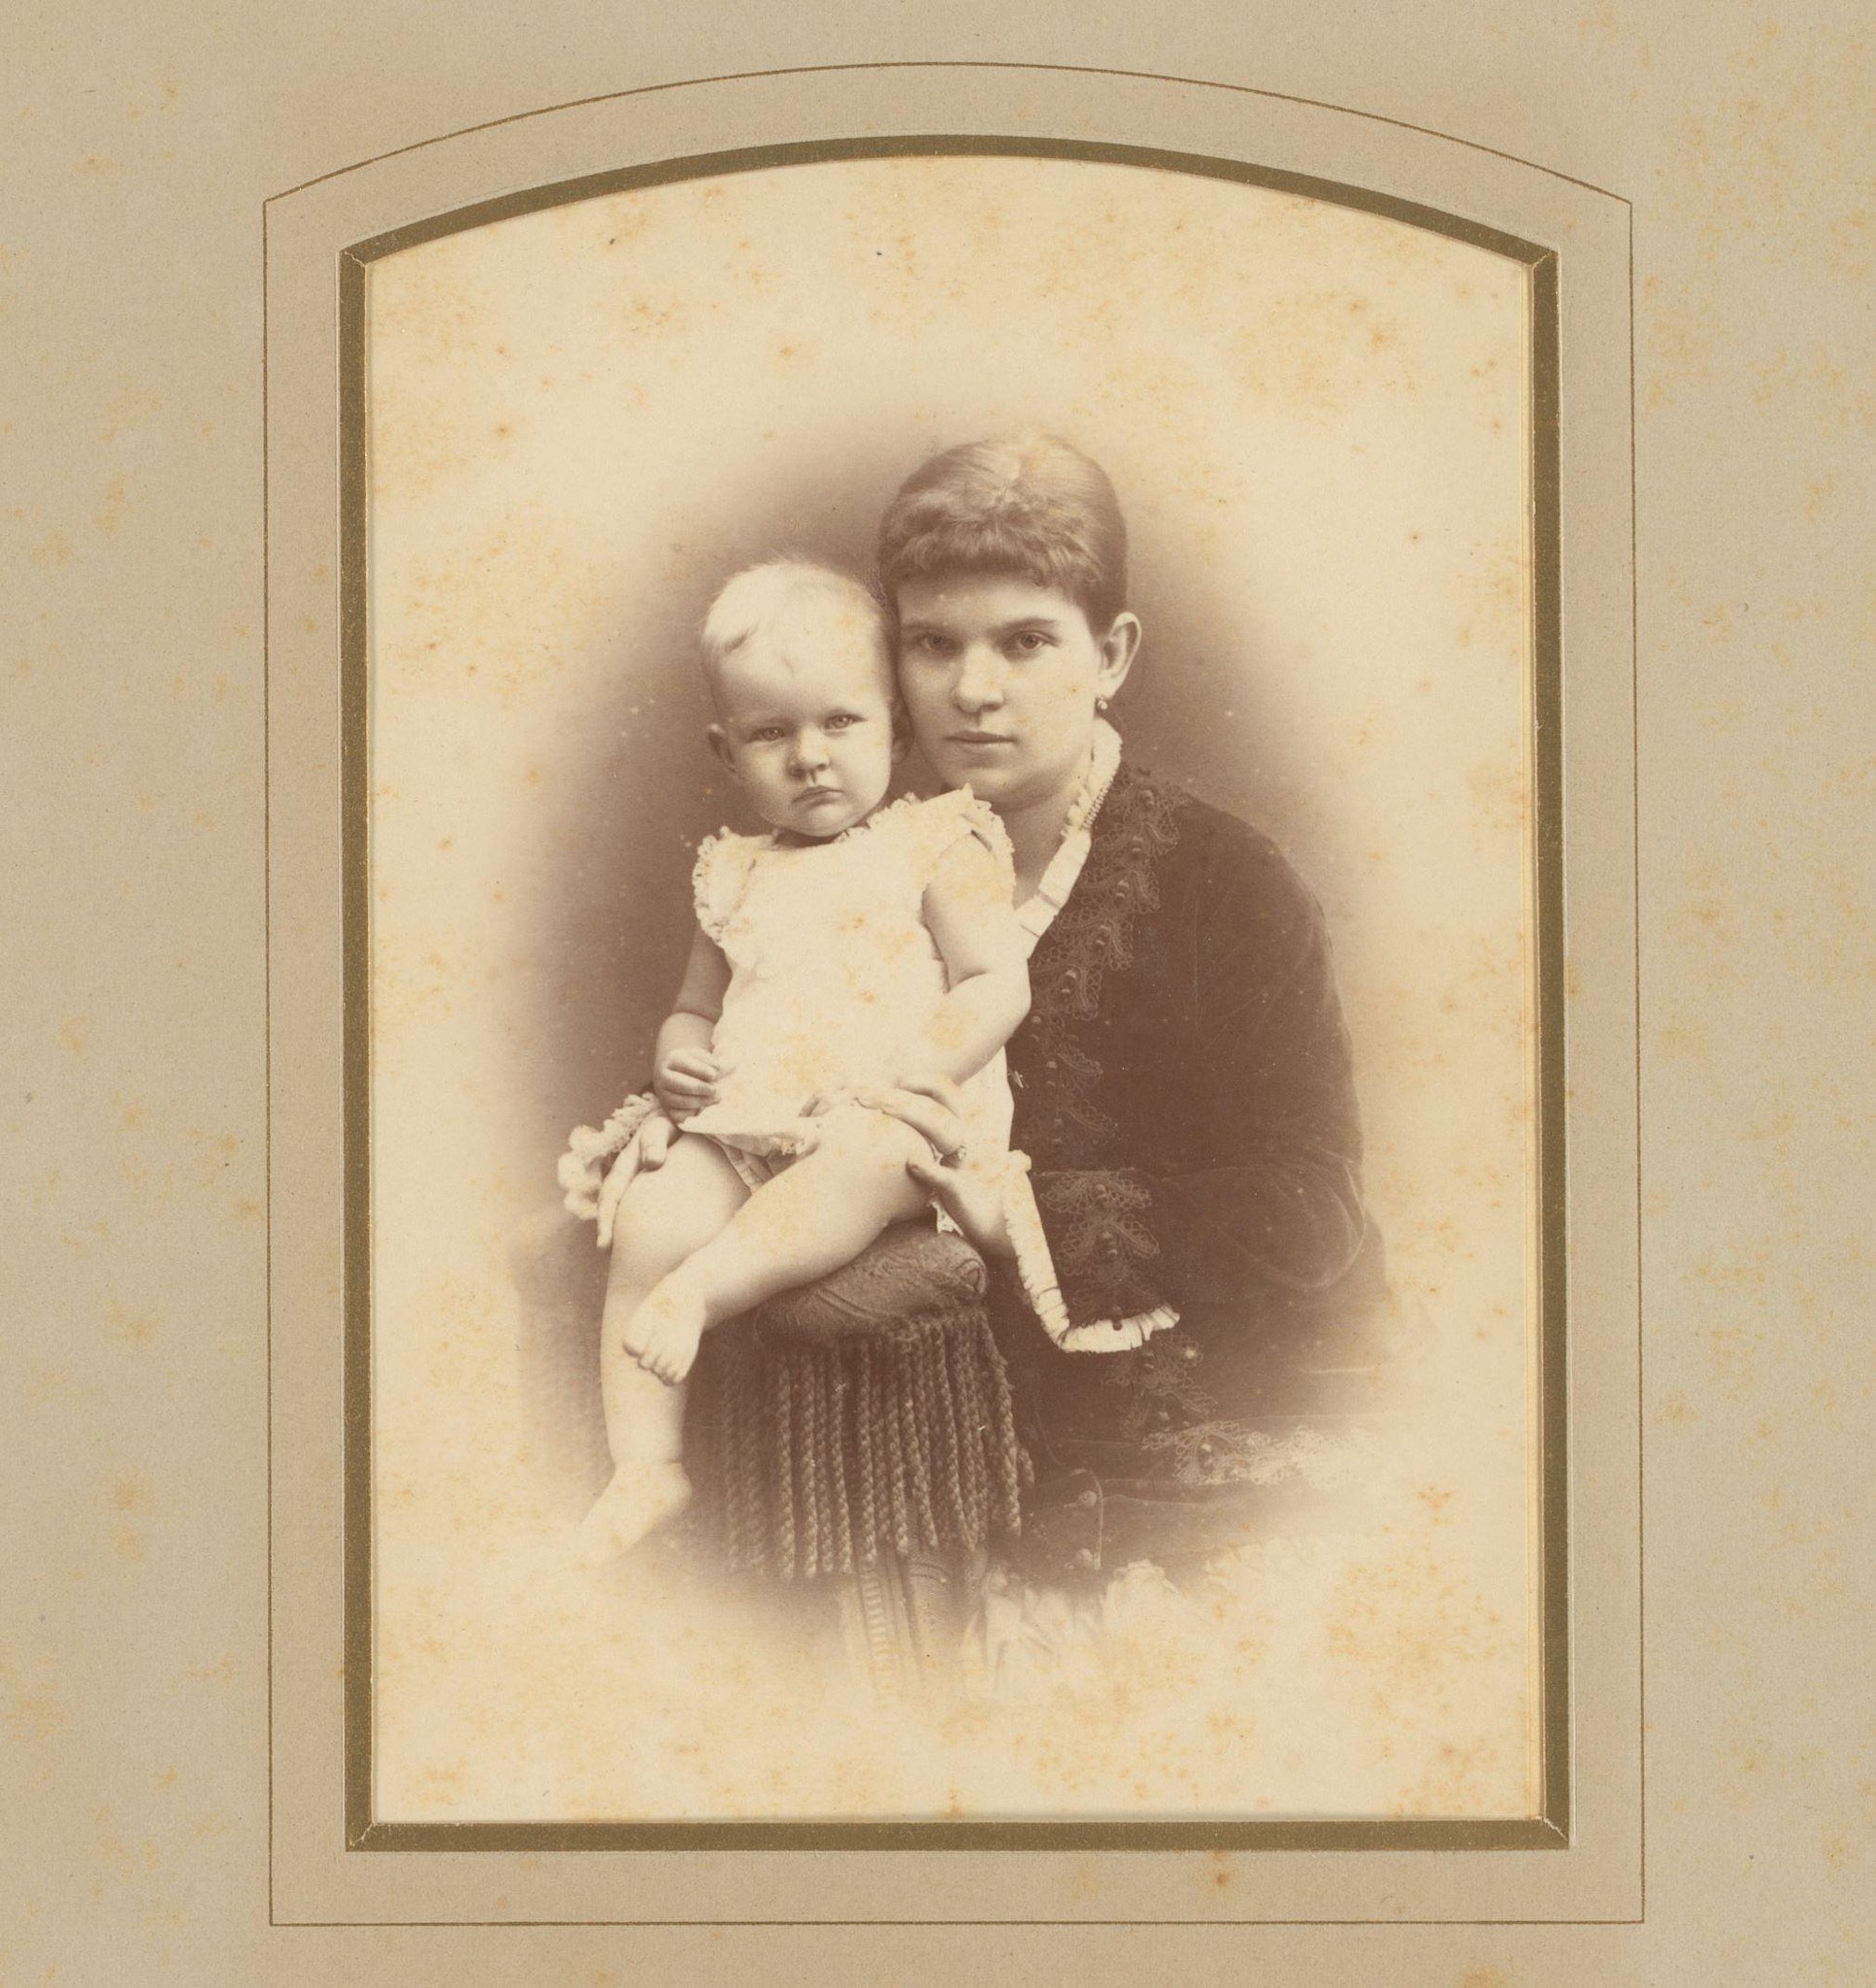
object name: photograph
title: Margo Kessler de Lange met An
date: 1884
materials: paper, photographic support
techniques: albumen print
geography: jakarta